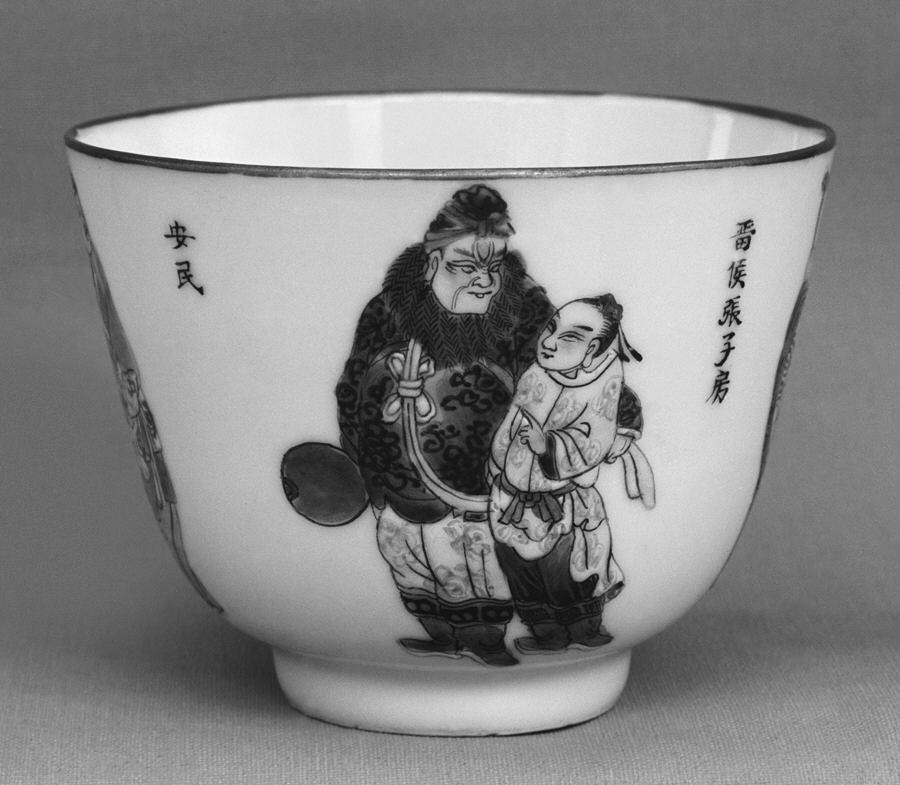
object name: cup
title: Cup with historical figures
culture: chinese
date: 1834-1866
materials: enamel, porcelain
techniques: overglaze, painting, polychrome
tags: men